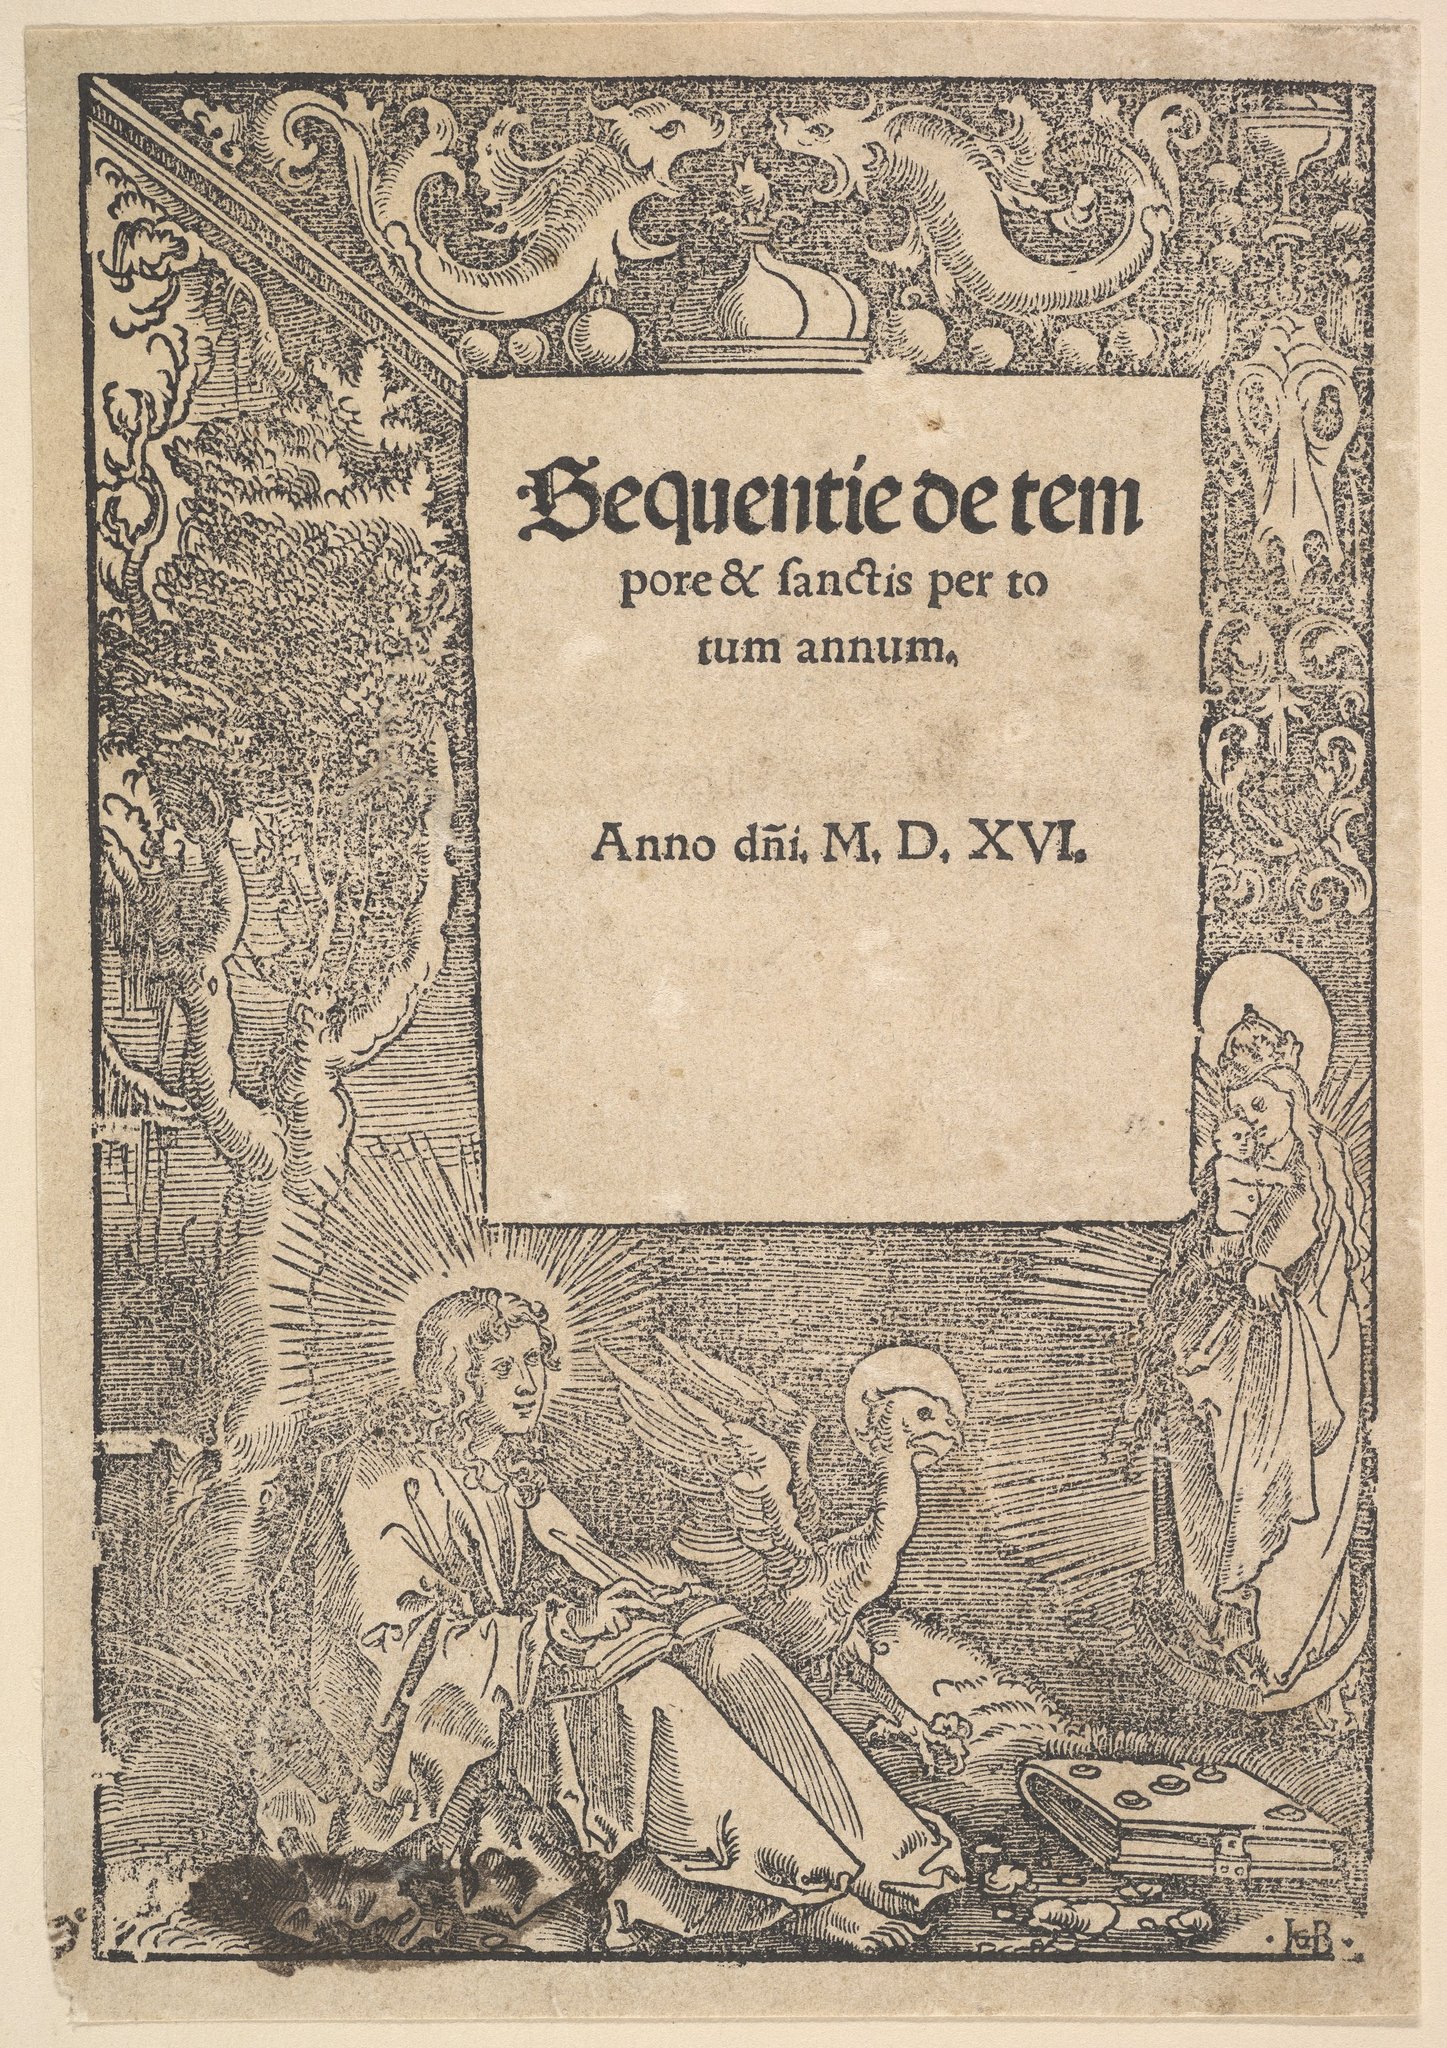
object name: print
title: Saint John the Evangelist on Patmos, title page from Hymni de tempore et de sanctis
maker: hans baldung (called hans baldung grien)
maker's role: artist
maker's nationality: german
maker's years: 1484-1545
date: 1516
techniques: letterpress, woodcut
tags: birds,madonna and child,saint john the evangelist